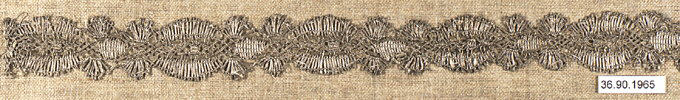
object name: piece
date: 1701-1800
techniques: lace